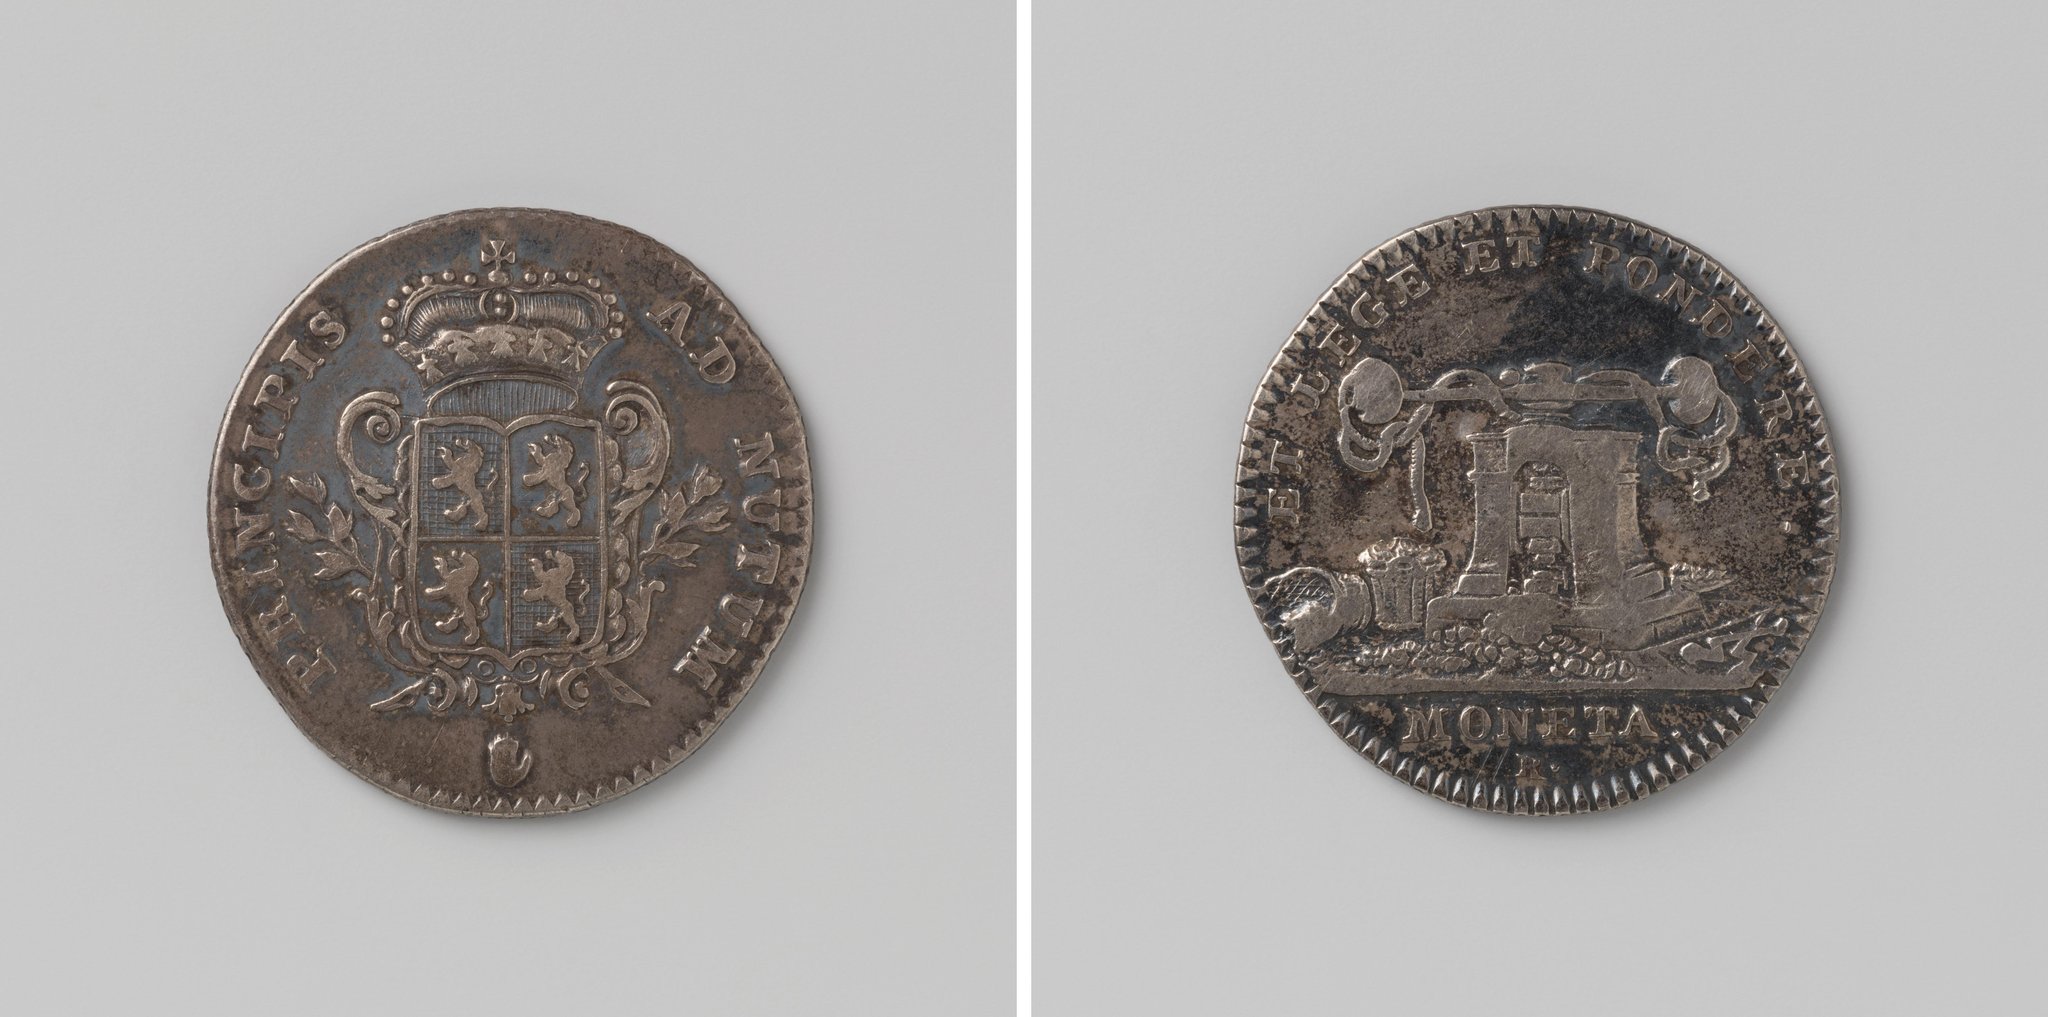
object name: jeton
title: Proefslag van de munt van Antwerpen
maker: jacques roëttiers (ii)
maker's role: medailleur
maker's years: 1698-1772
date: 1744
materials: silver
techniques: striking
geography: antwerp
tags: antwerp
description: Zilveren penning. Voorzijde: gekroond wapenschild in cartouche binnen omschrift. Keerzijde: balanspers binnen omschrift; afsnede: opschrift boven signatuur